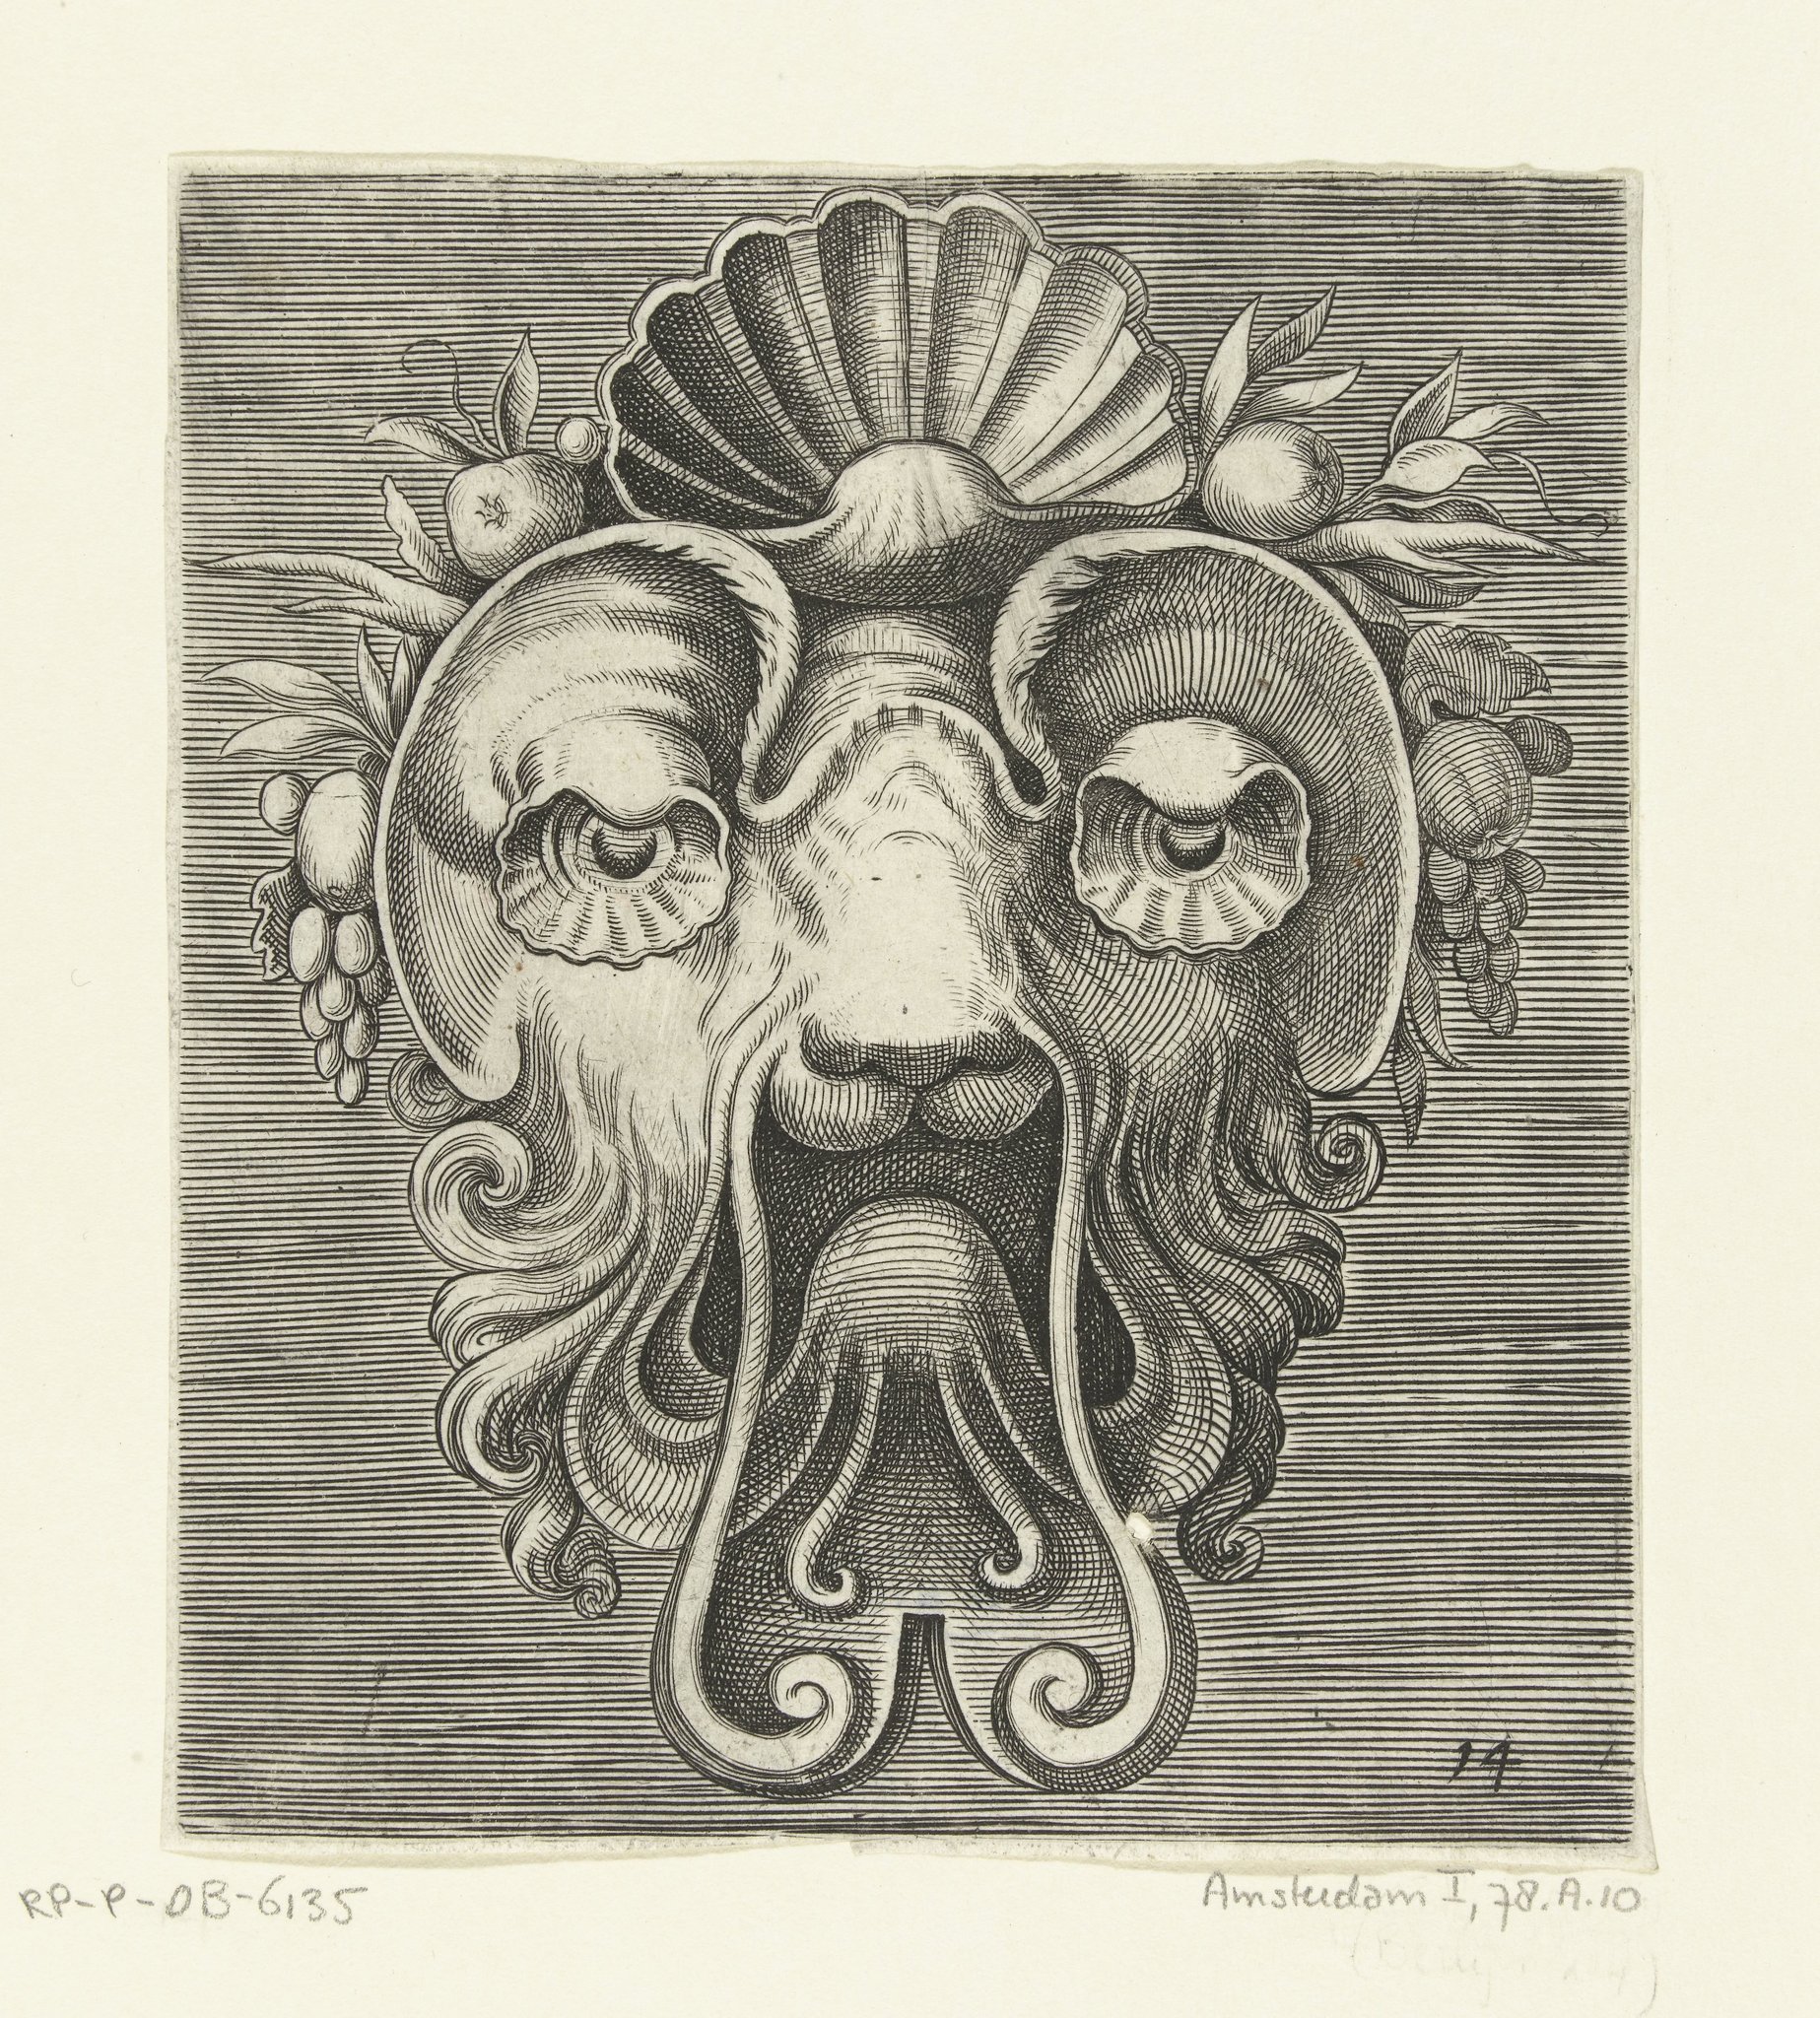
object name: ornament print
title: Pourtraicture ingenieuse de plusieurs facons de masques…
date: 1600-1650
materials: paper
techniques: engraving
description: Blad hoort bij 11 ten dele genummerde bladen afkomstig uit een serie van 18 met als titel 'Pourtraicture ingenieuse de plusieurs façons de masques...'. Het betreft de tweede editie van een serie die beschreven is onder Orn Cat I-78.1 t/m 11.